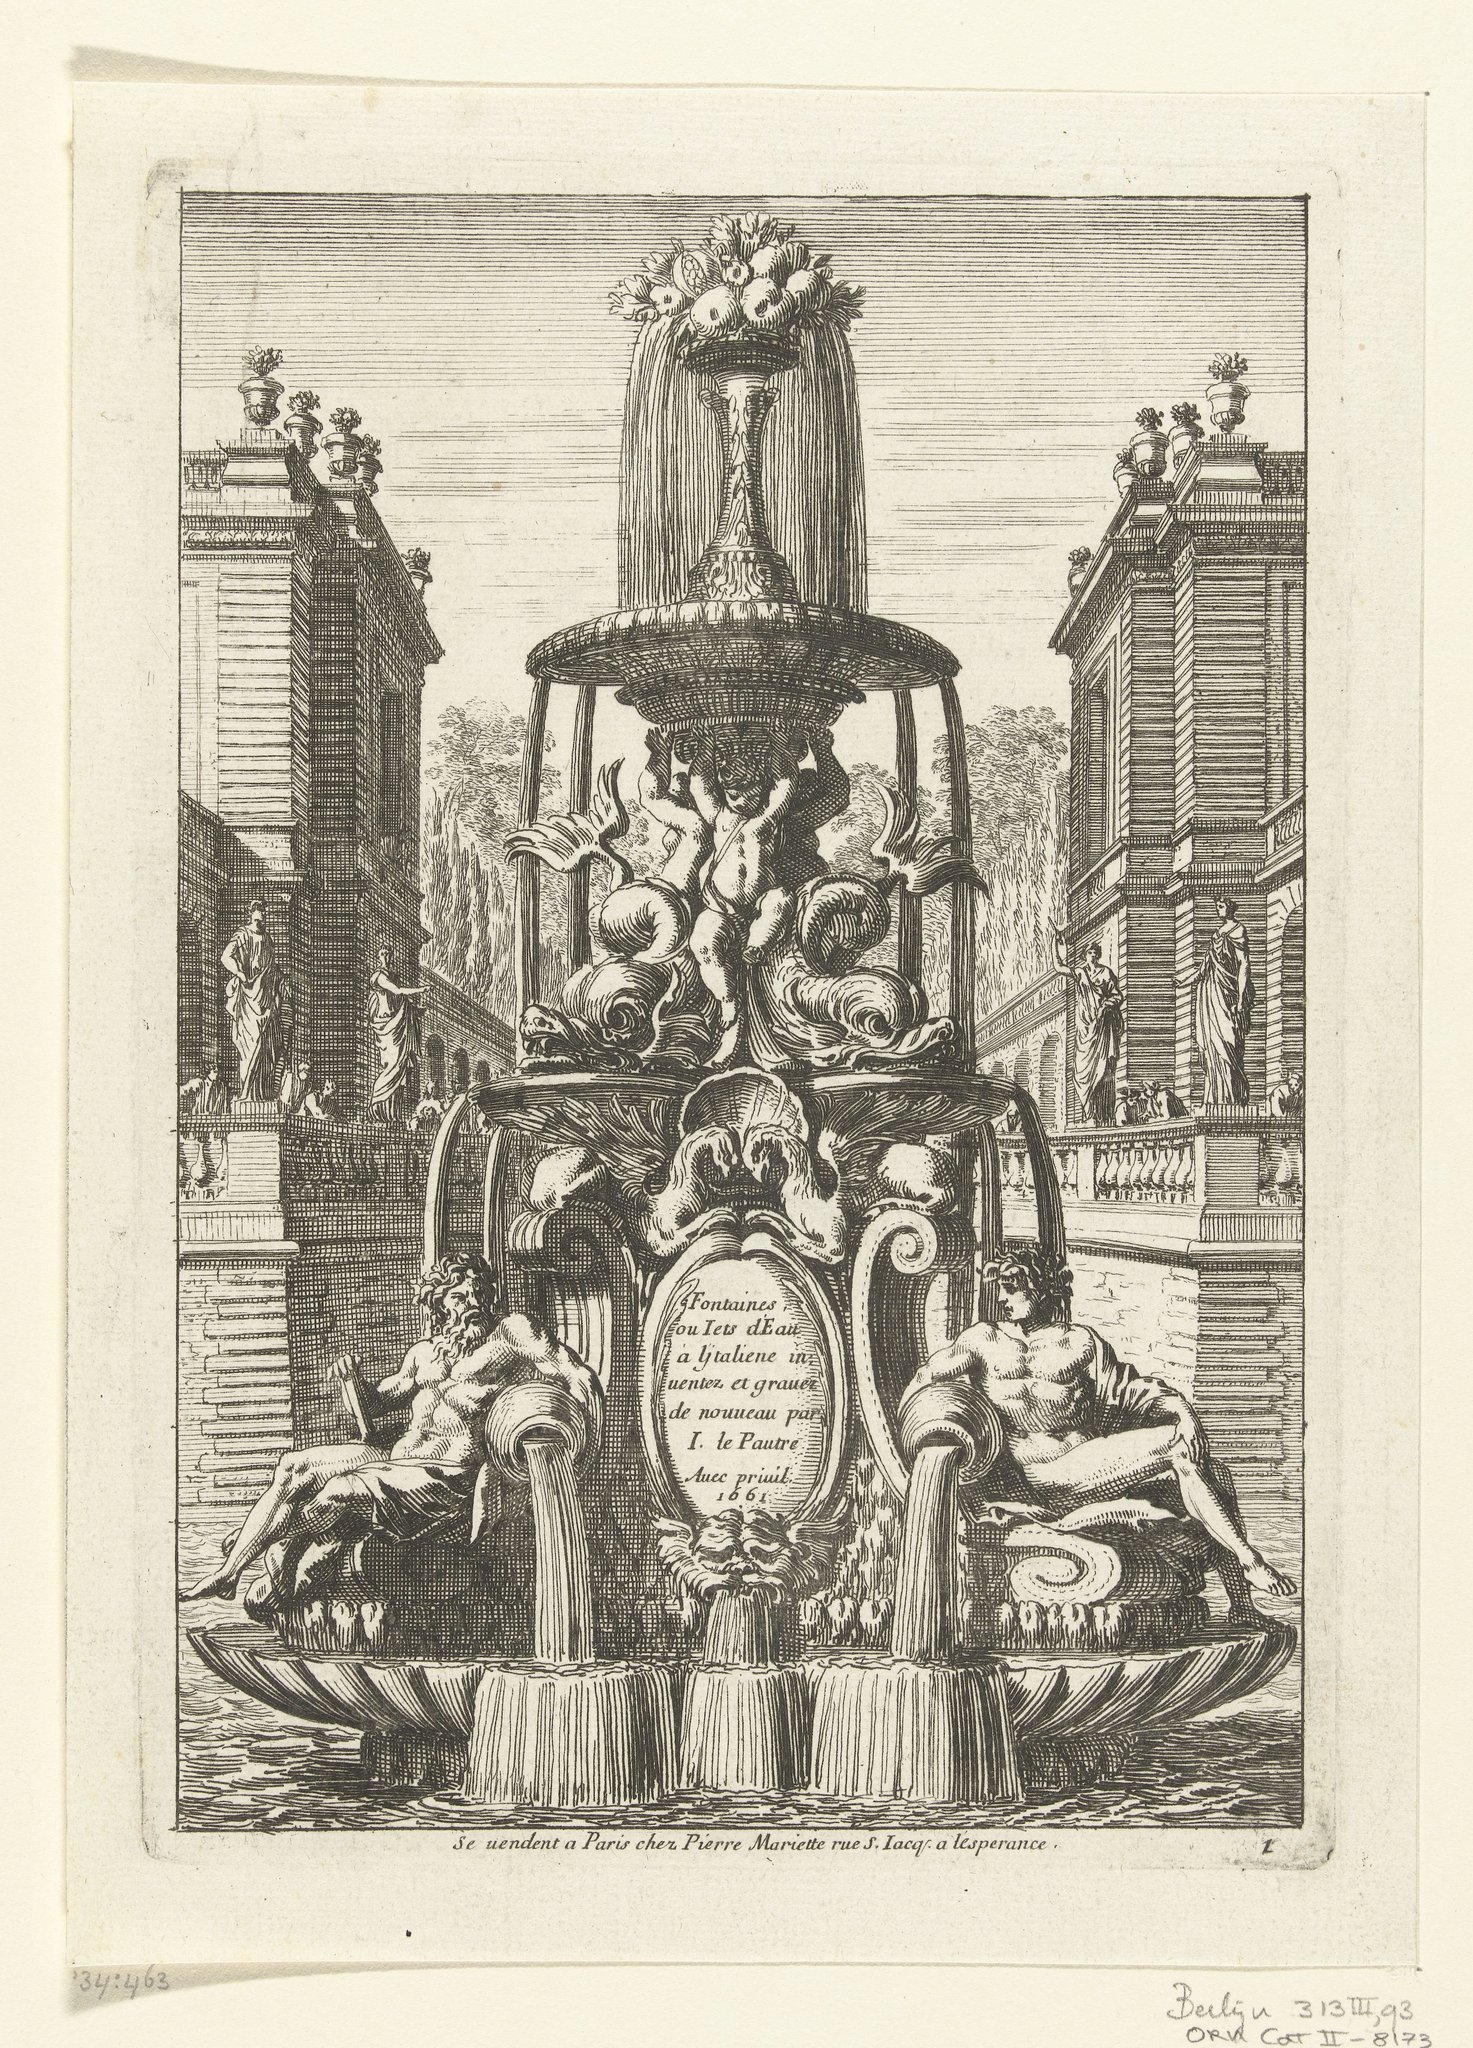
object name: print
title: Titelblad: Fontaines, ou Jets d'Eau à l'italienne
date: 1661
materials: paper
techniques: etching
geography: france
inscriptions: date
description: Fontein met drie verdiepingen, onderaan zitten twee riviergoden, bovenaan staat een fruitmand.